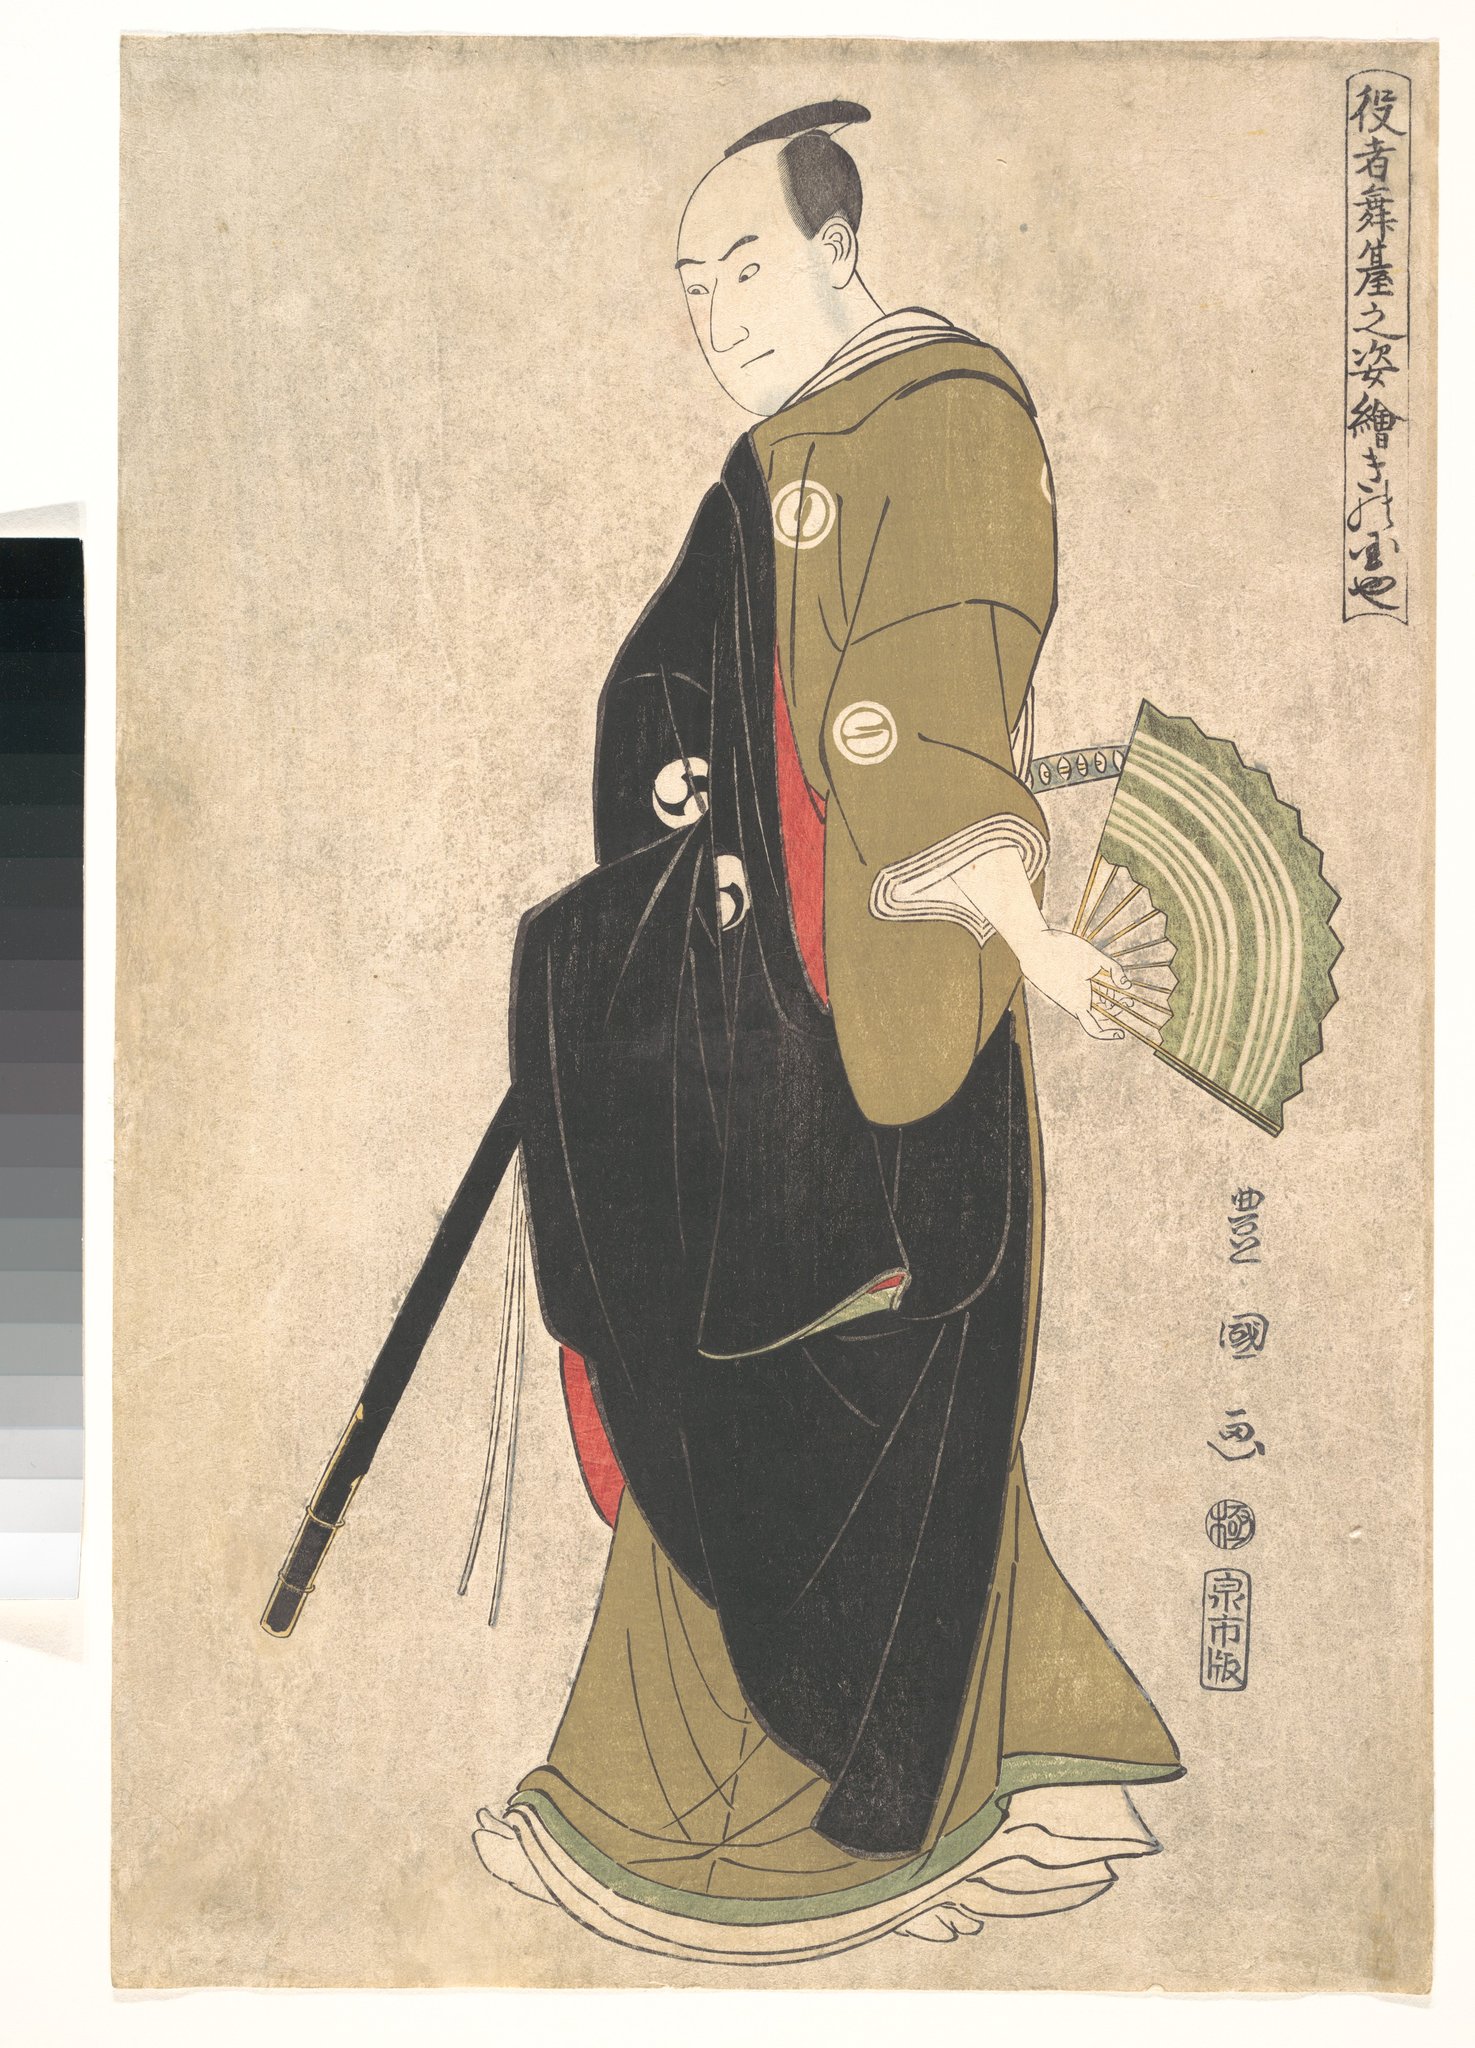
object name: print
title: The Actor Sawamura Sōjūrō 3rd (Kinokuniya)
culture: japanese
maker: utagawa toyokuni i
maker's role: artist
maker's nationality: japanese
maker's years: 1769-1825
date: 1795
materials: ink, mica, paper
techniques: woodblock print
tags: fans,men,actors